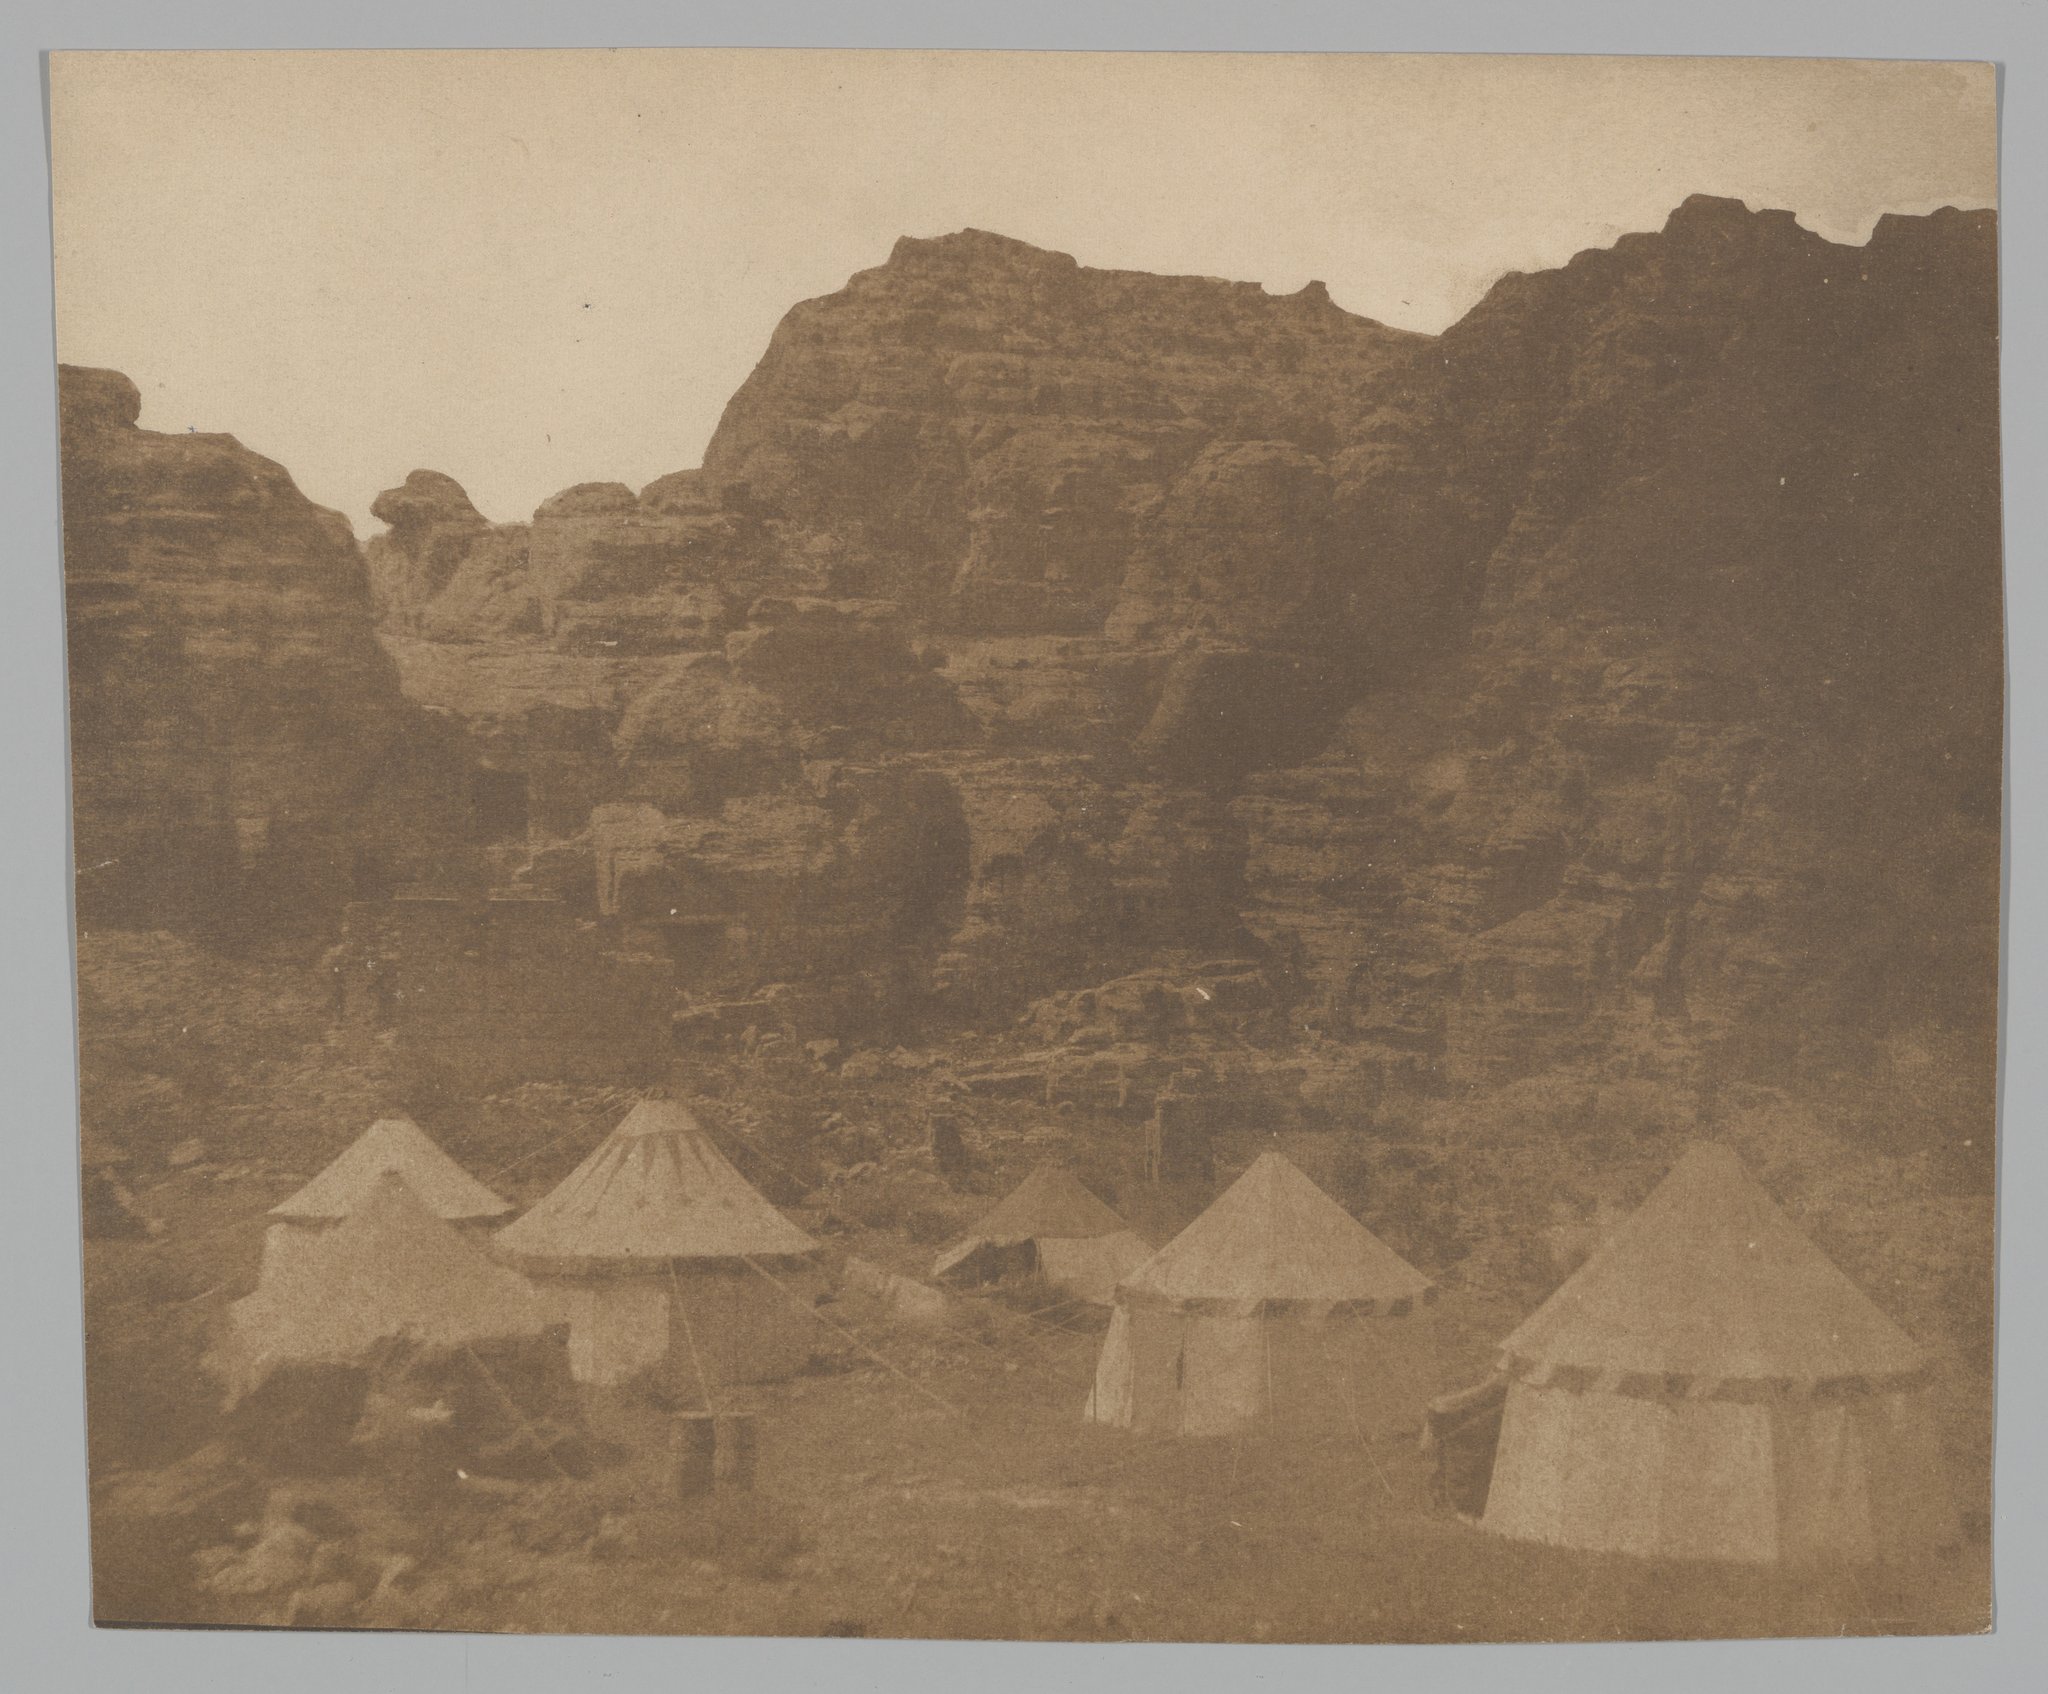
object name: photograph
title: [Expedition Camp, Petra]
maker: leavitt hunt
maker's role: artist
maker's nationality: american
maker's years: 1850-1859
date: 1852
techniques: paper negative, salted paper print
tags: tents,mountains,camps